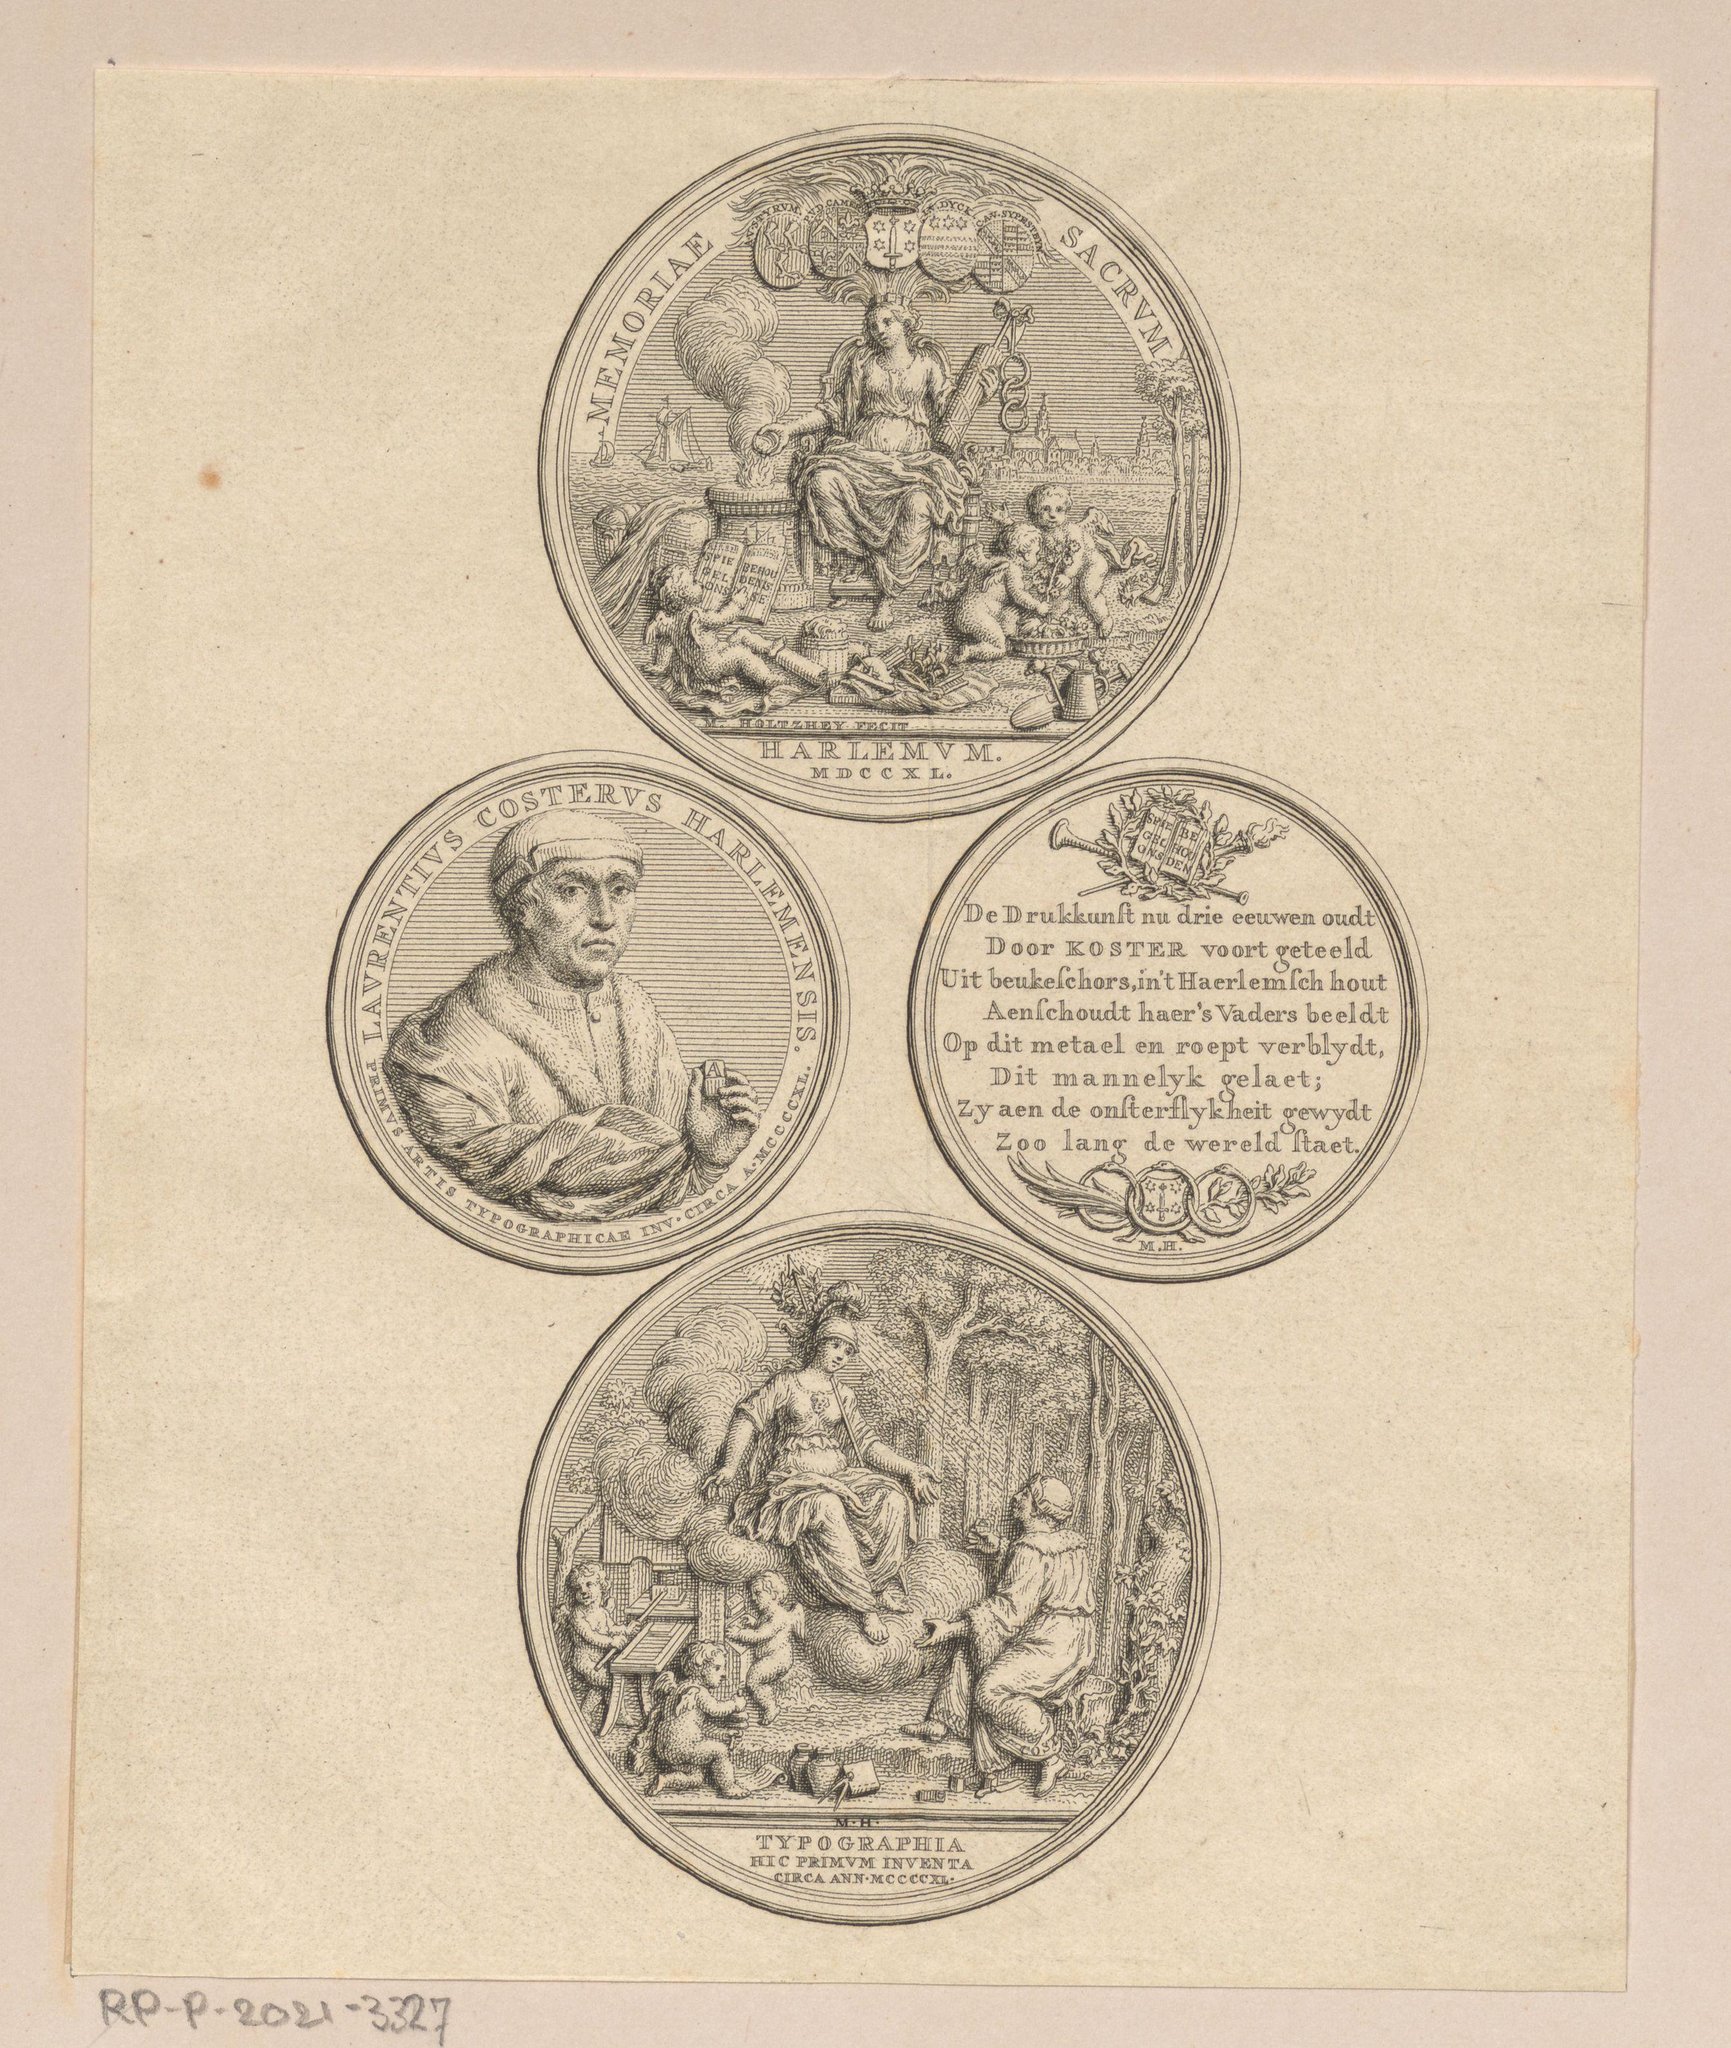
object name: print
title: Medailles met het portret van Laurens Janszoon Coster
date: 1740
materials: paper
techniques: etching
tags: haarlem, (story of) minerva (pallas, athena), historical persons, printing press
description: Twee medailles, één met het portret van Laurens Janszoon Coster op één zijde en een tekst over drukpers op de andere zijde. Op de andere medaille aan één zijde de personificatie van de stad Haarlem en aan de andere zijde Coster die knielt aan de voeten van Minerva.